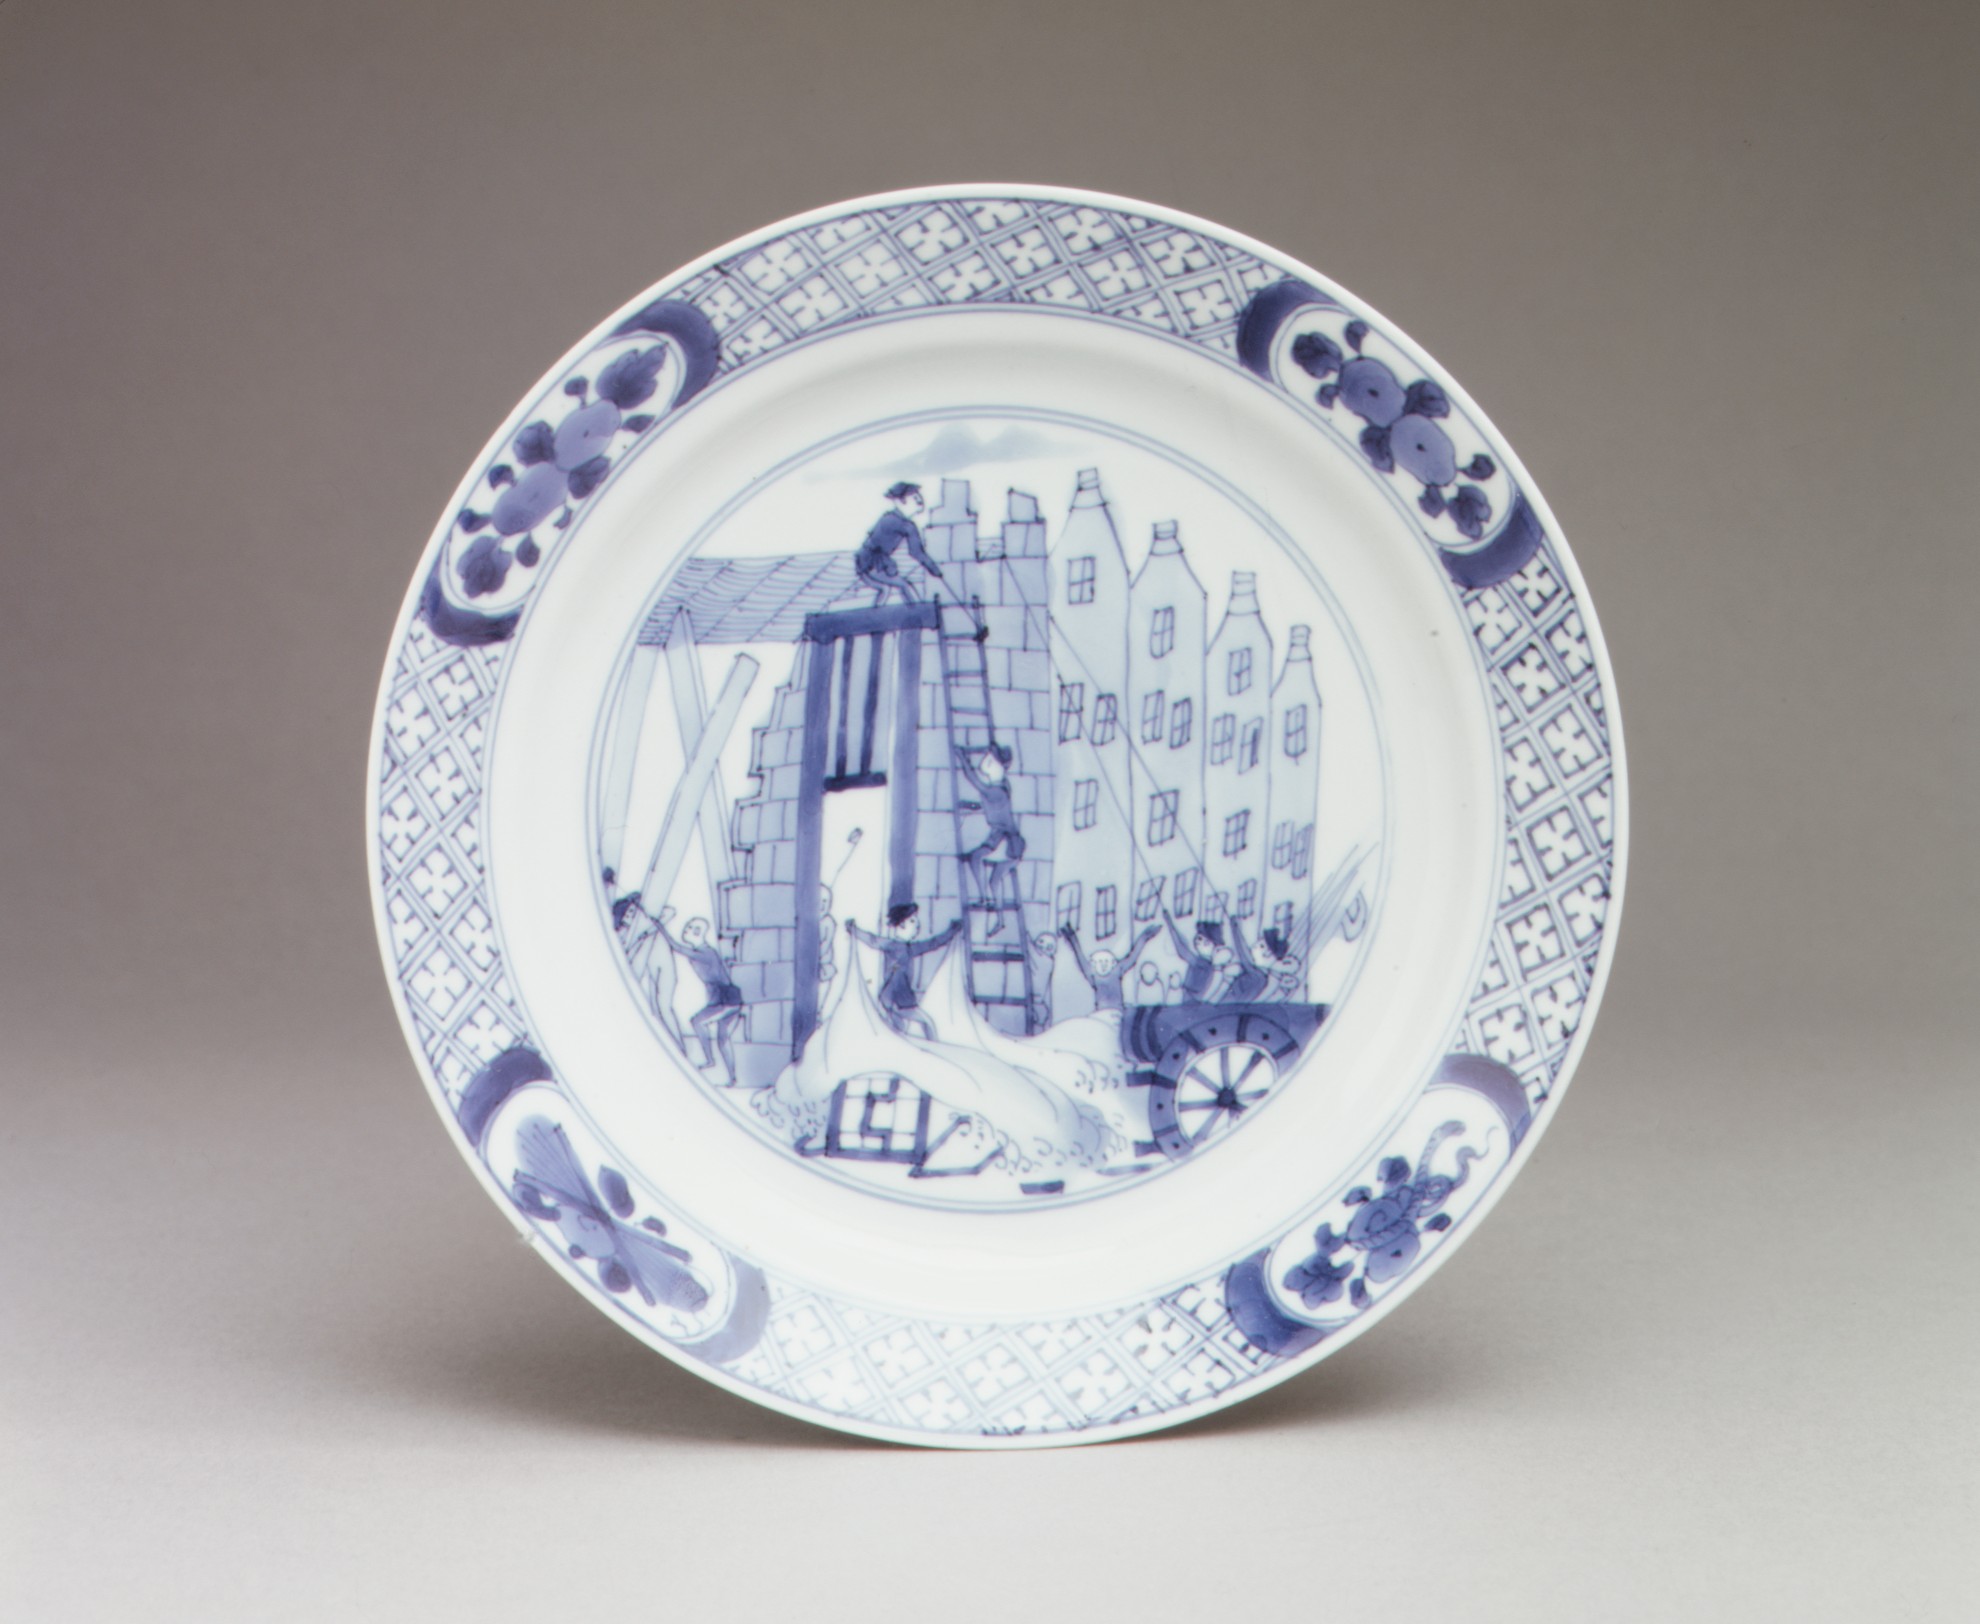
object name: plate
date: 1700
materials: hard paste porcelain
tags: men